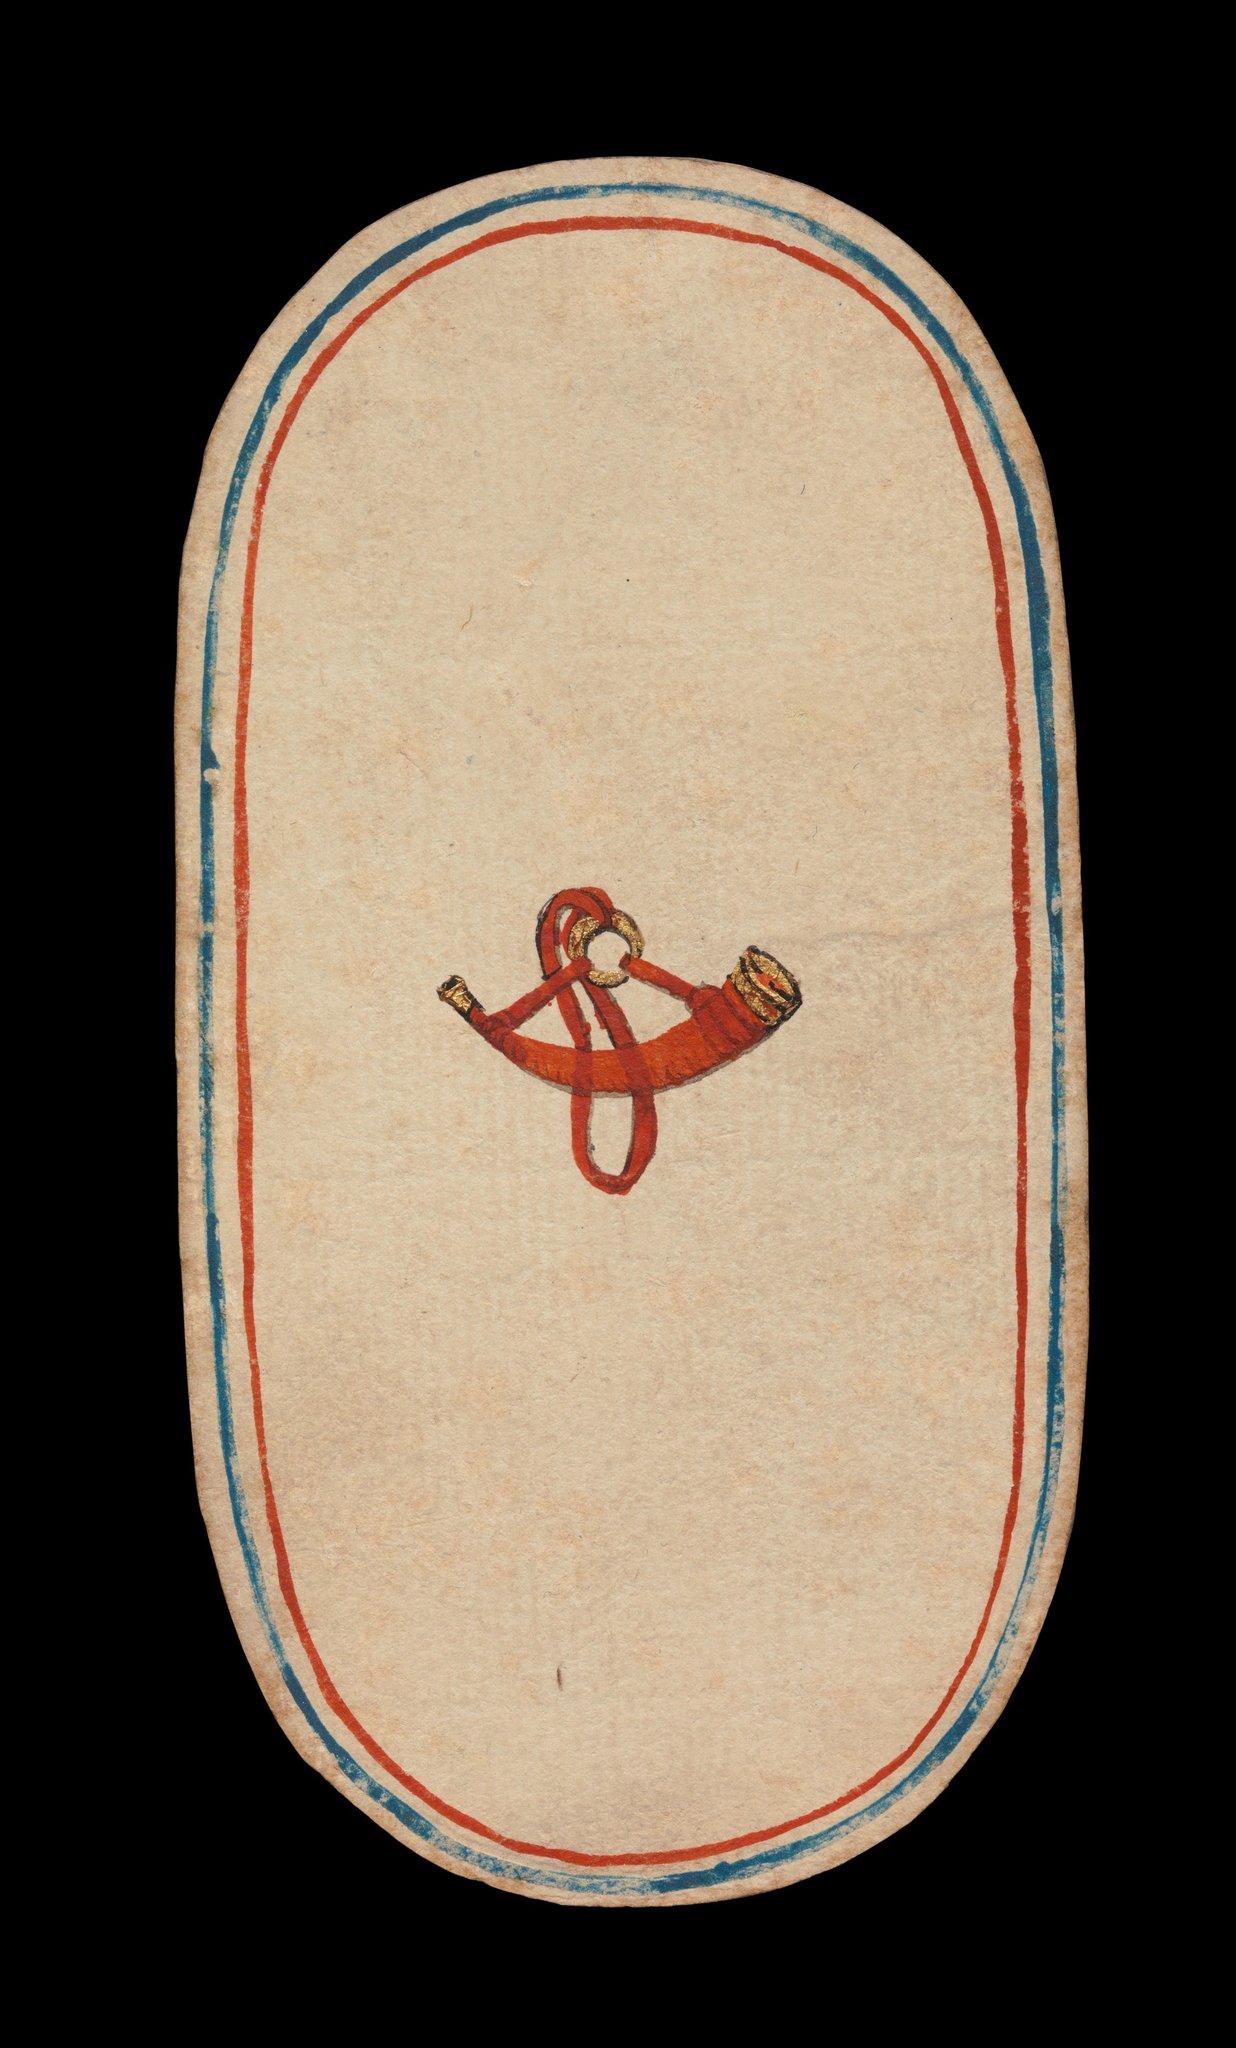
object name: playing card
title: 1 of Horns, from The Cloisters Playing Cards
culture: south netherlandish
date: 1475-1480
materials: glaze, gold, ink, paint, paper, silver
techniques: pen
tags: playing cards,horns,games